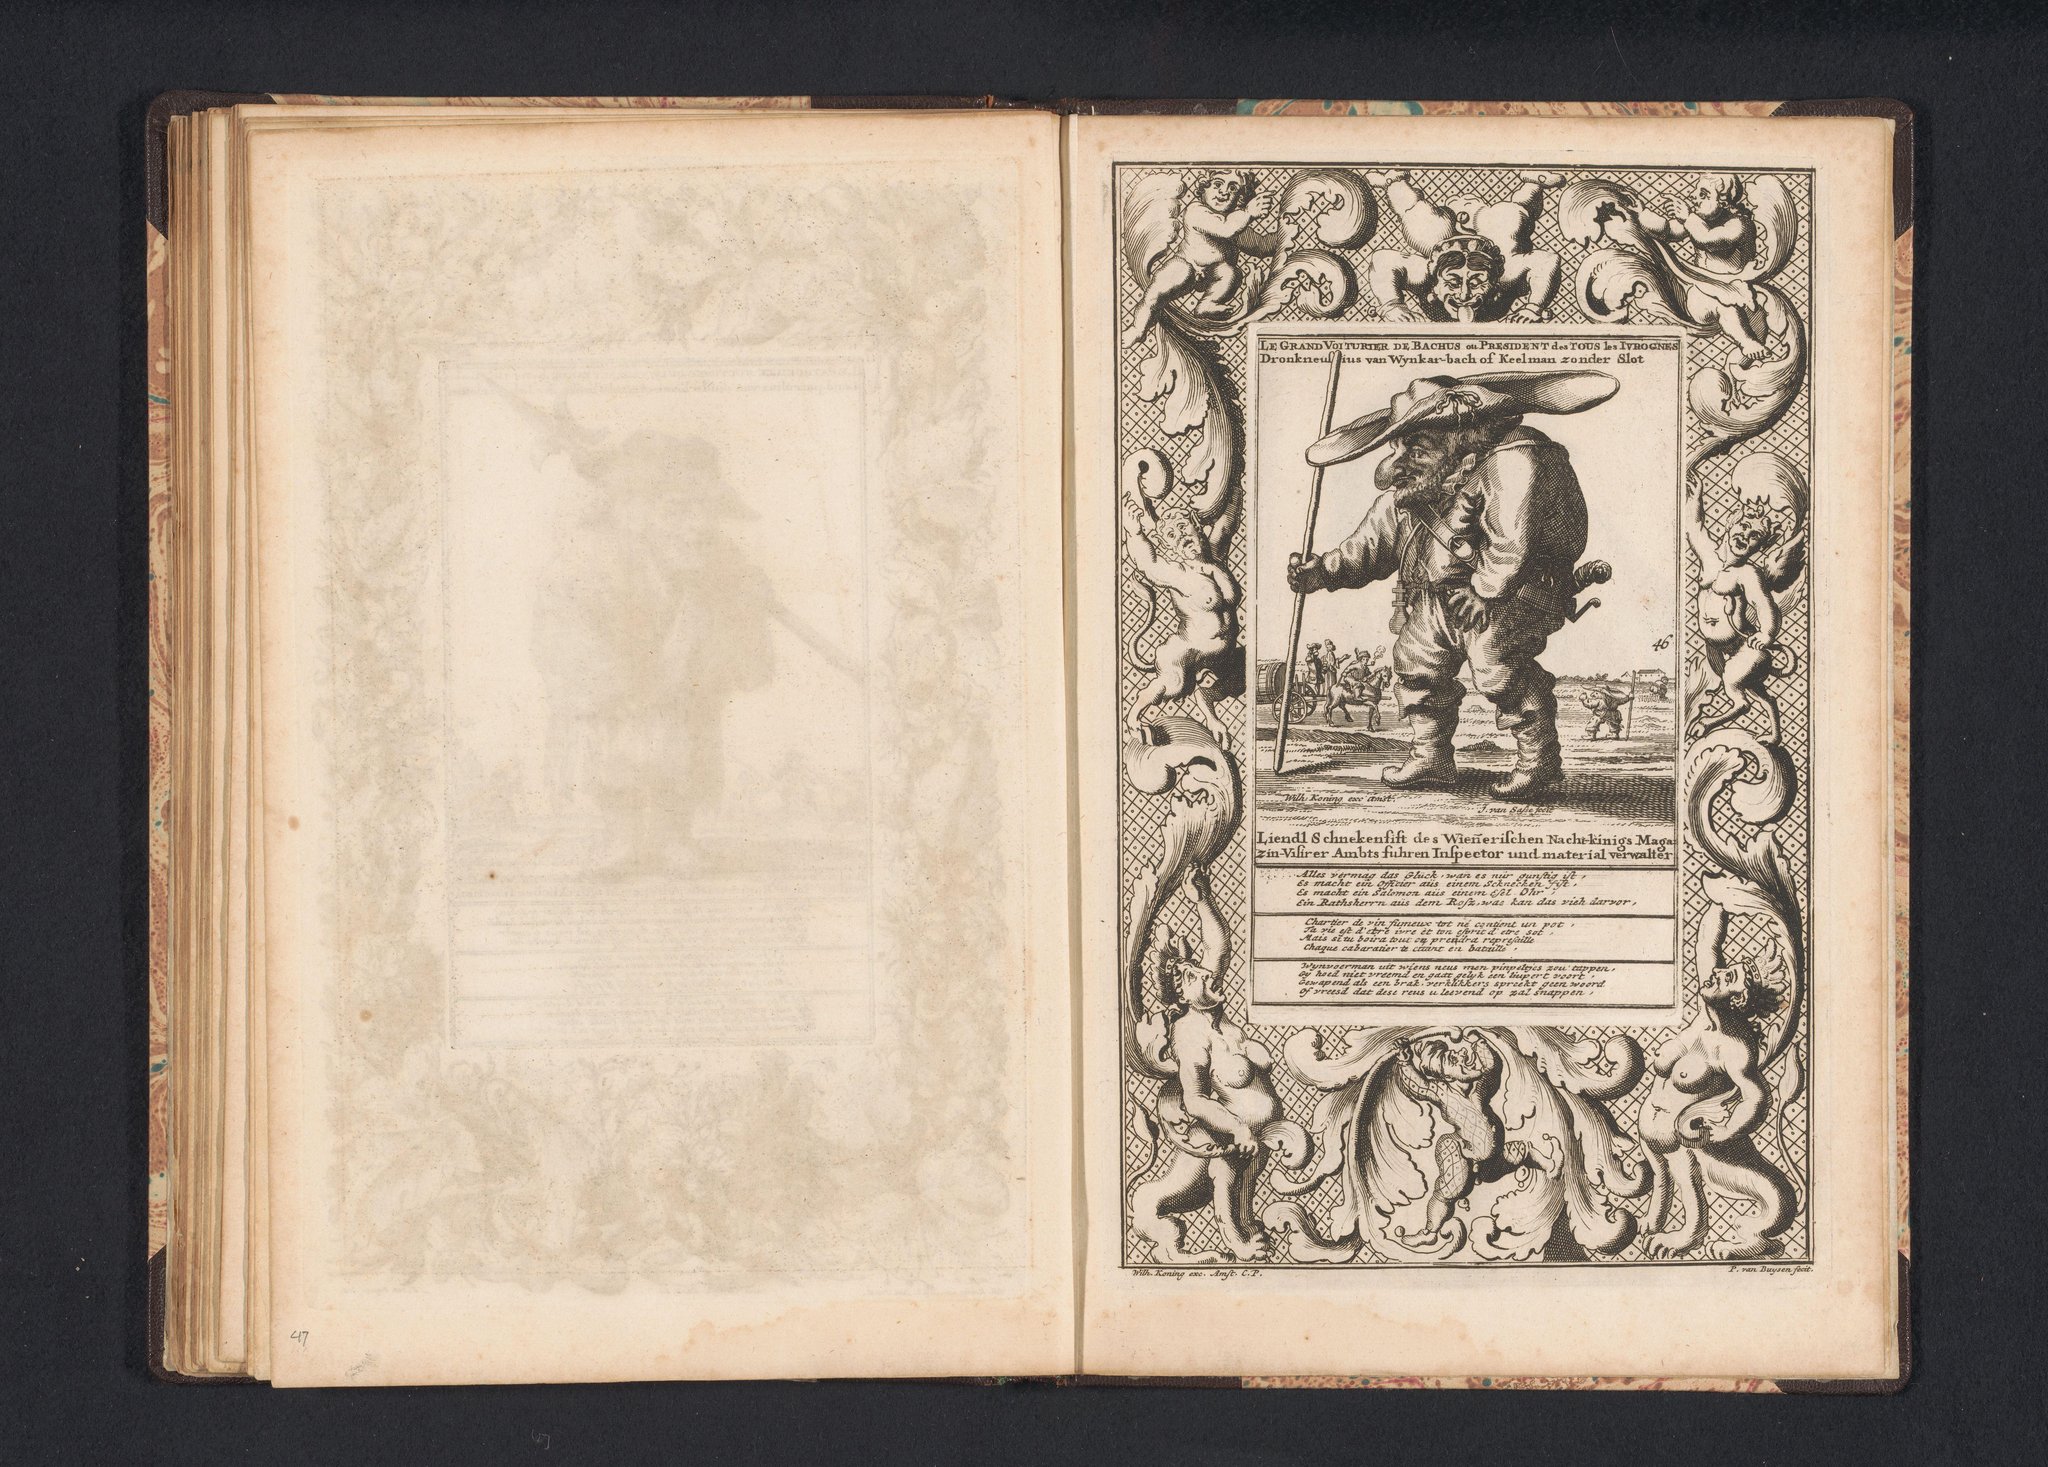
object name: caricature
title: De kleine mens Dronkneussius van Wynkar-bach, 1716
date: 1716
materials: paper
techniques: etching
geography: amsterdam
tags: caricatures (human types), little people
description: De kleine mens Dronkneussius van Wynkar-bach als inspecteur te Wenen. In het onderschrift verzen in het Duits, Frans en Nederlands. Afdruk binnen een decoratieve omlijsting gedrukt van een aparte plaat met monsters en een harlekijn. Genummerd rechts midden: 46. Onderdeel van de Nederlandse gebonden uitgave uit 1716 van een serie karikaturen van kleine mensen, bekend als Het Dwergentooneel, gekopieerd naar een ouder Duits voorbeeld.